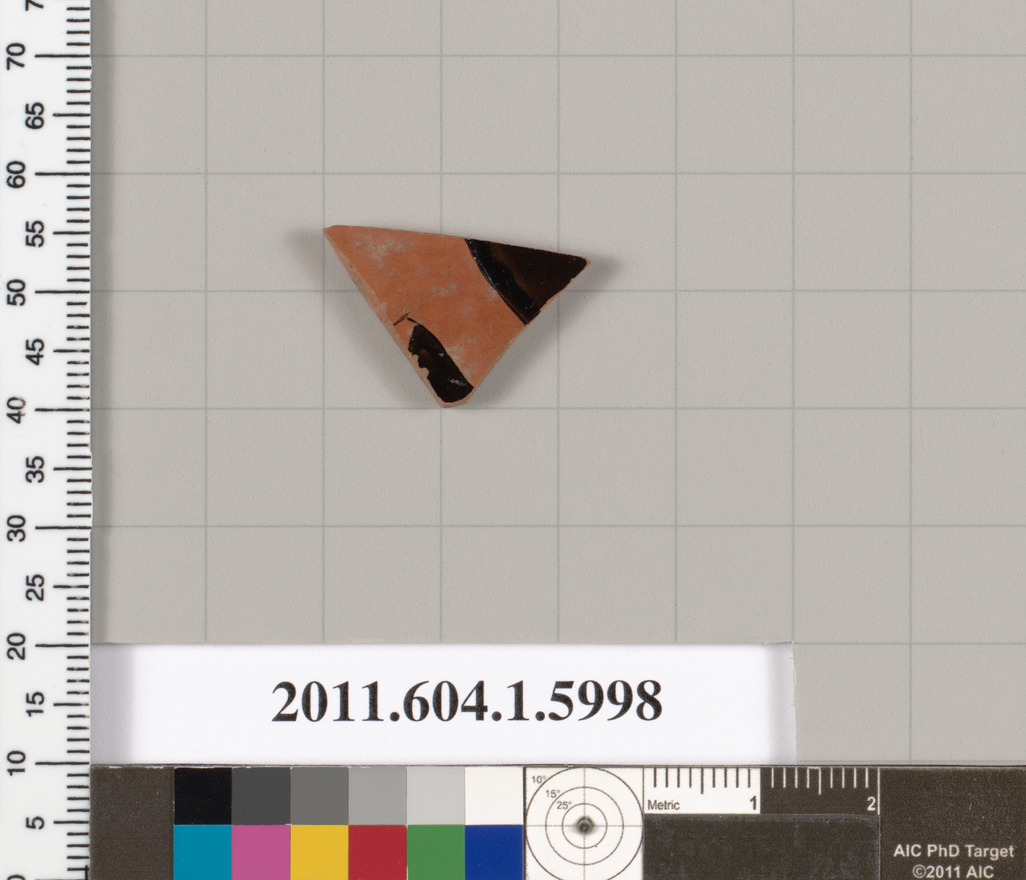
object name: kylix fragment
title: Terracotta fragment of a kylix (drinking cup)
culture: greek, attic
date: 510-500 BCE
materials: terracotta